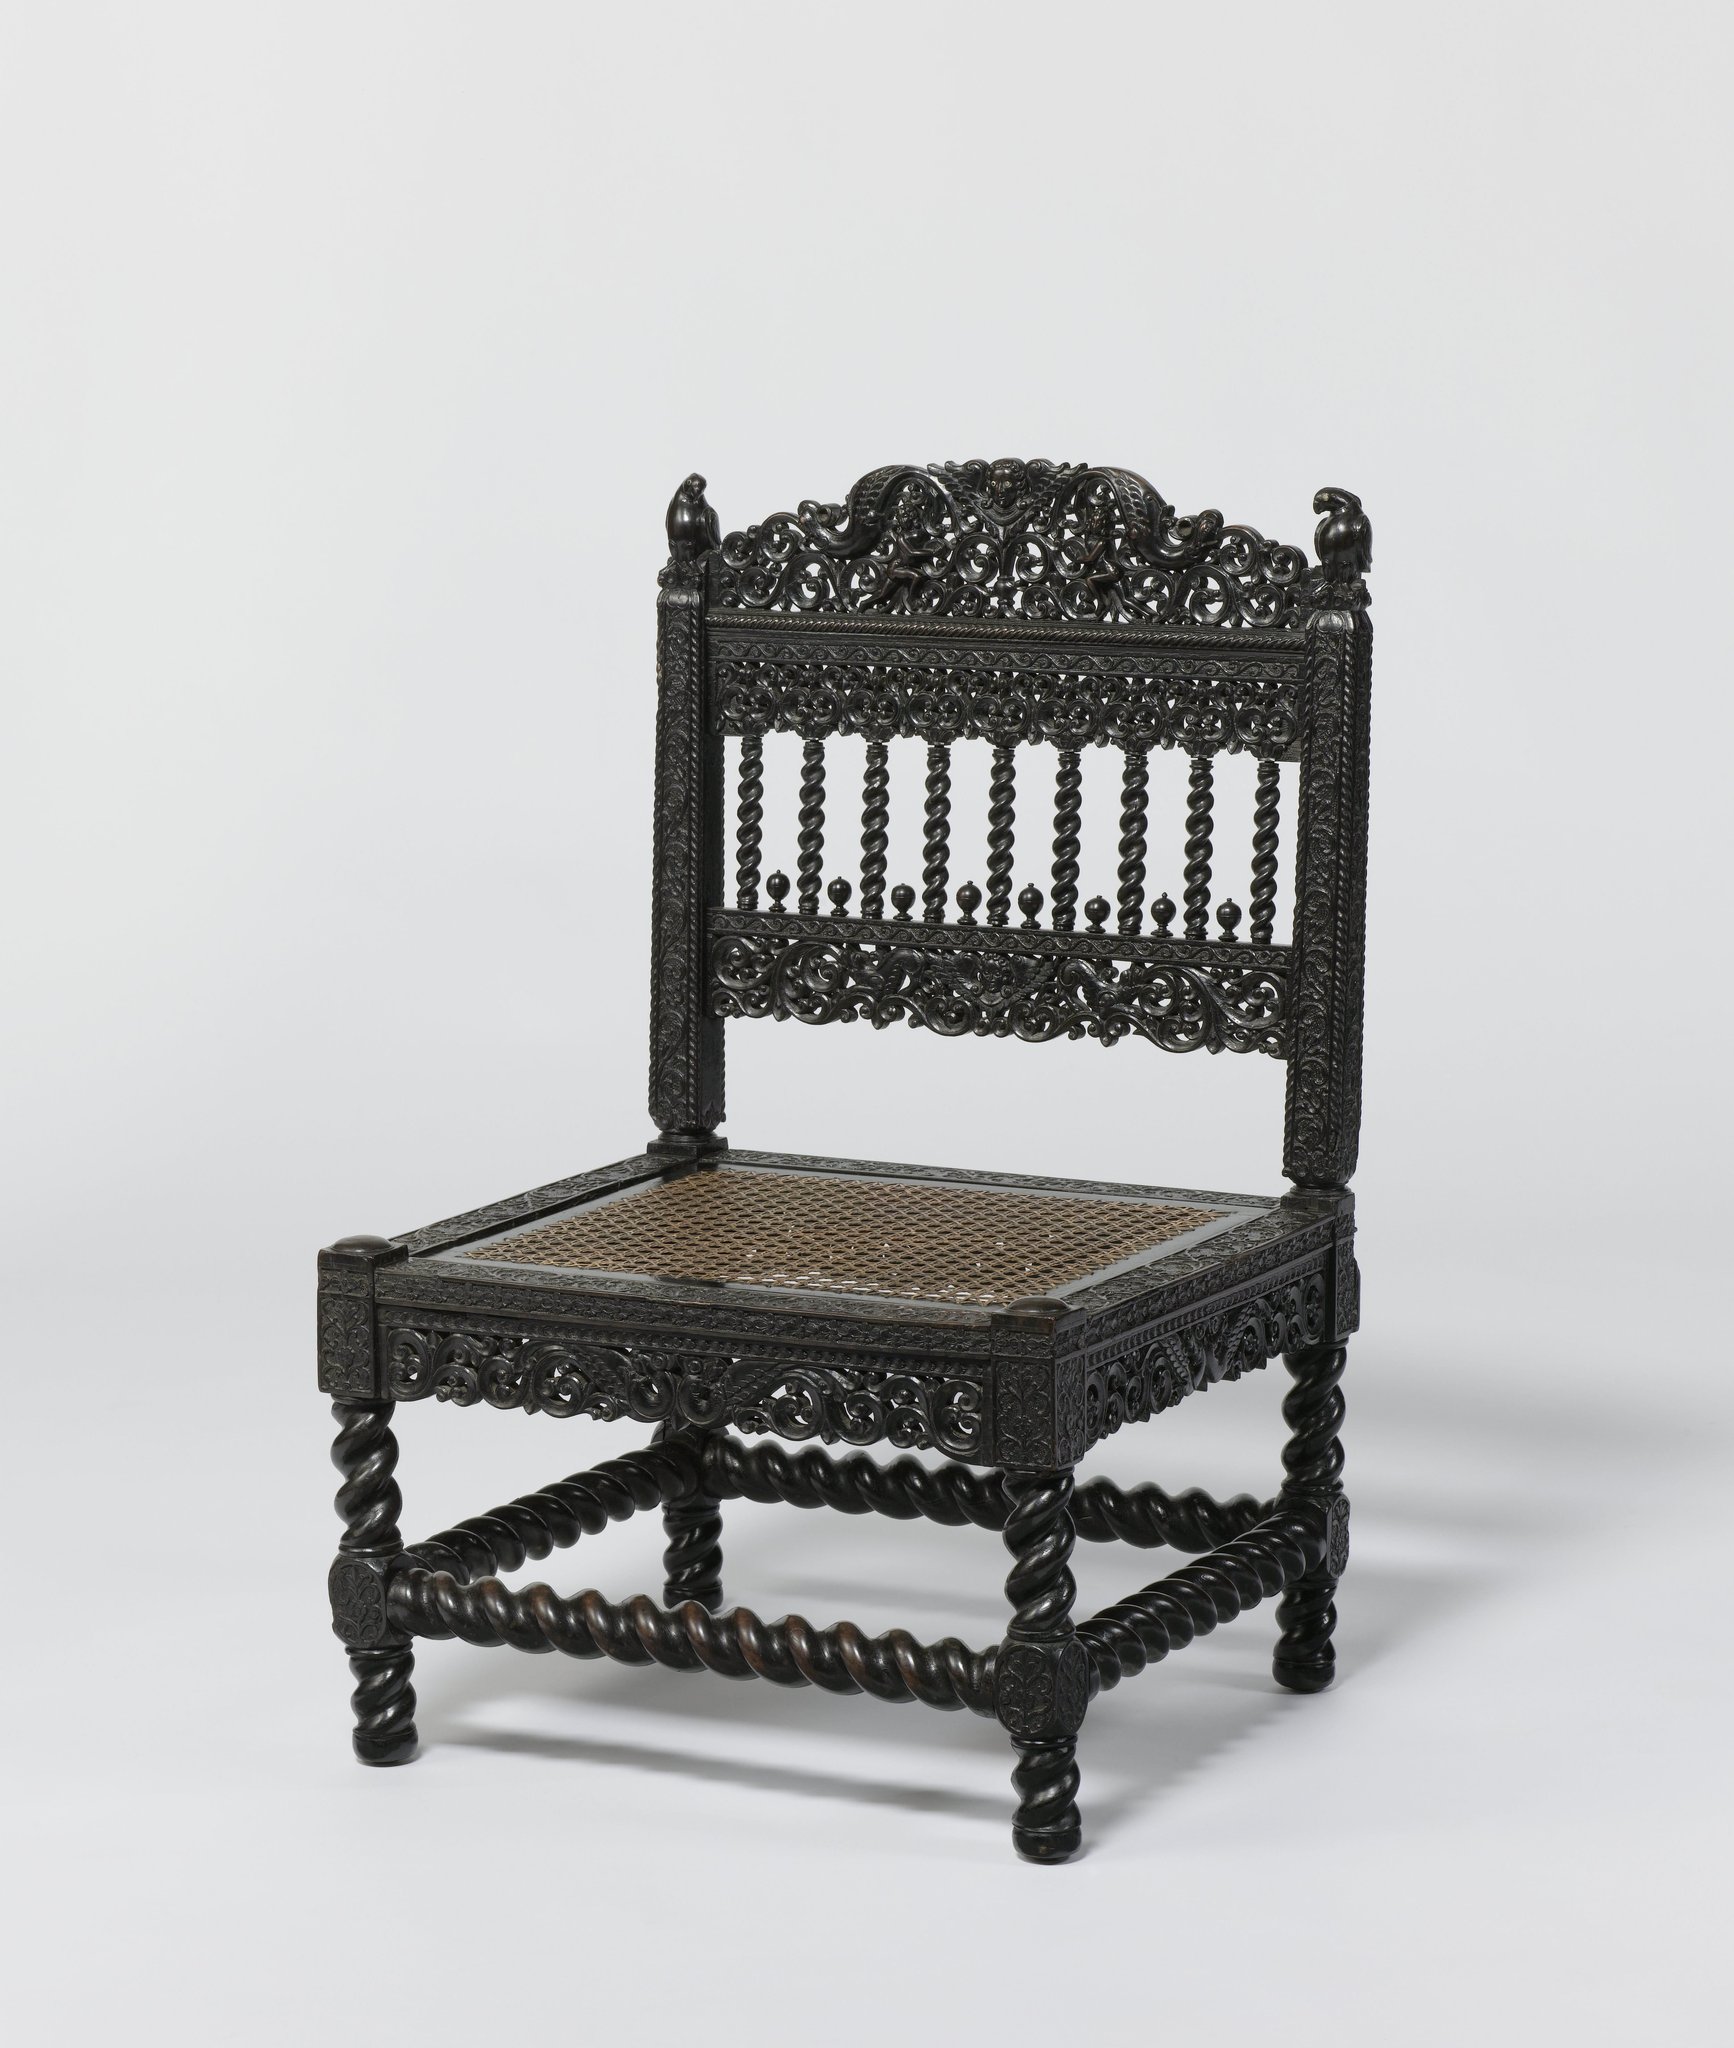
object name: furniture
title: Stoel met op rugstijlen papegaaiachtige vogels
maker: Anonymous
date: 1660-1680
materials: bone, wood, ivory, rattan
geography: india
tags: sri lanka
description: Chair. Ebony, cane. Ceylon, 1650 - 1700.